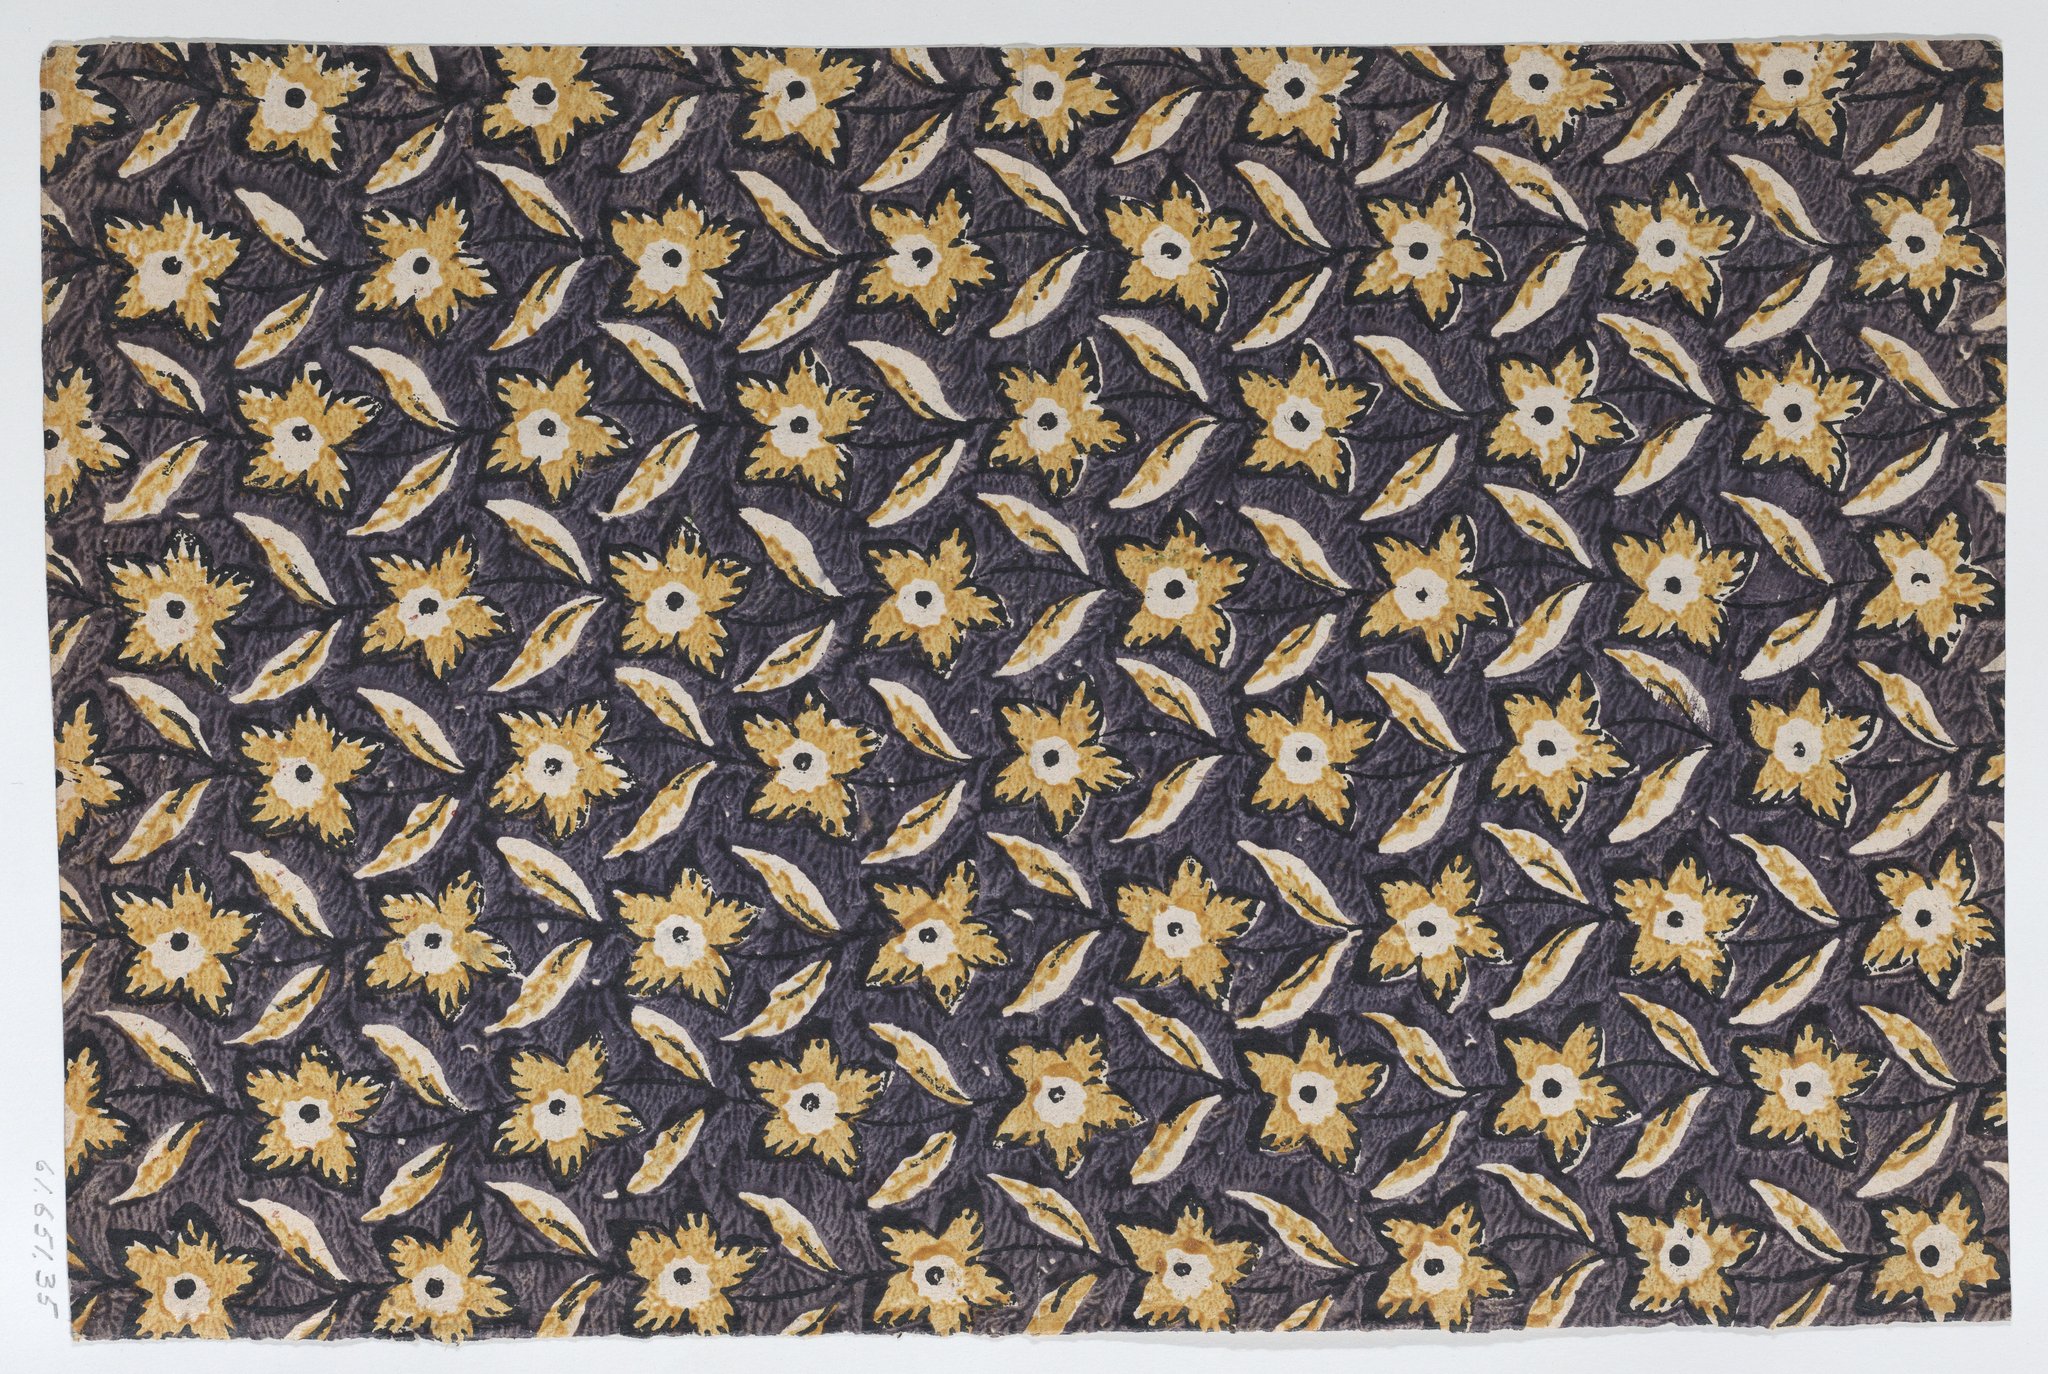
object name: print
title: Book cover with overall floral design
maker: Anonymous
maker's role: artist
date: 1801-1900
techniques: relief print